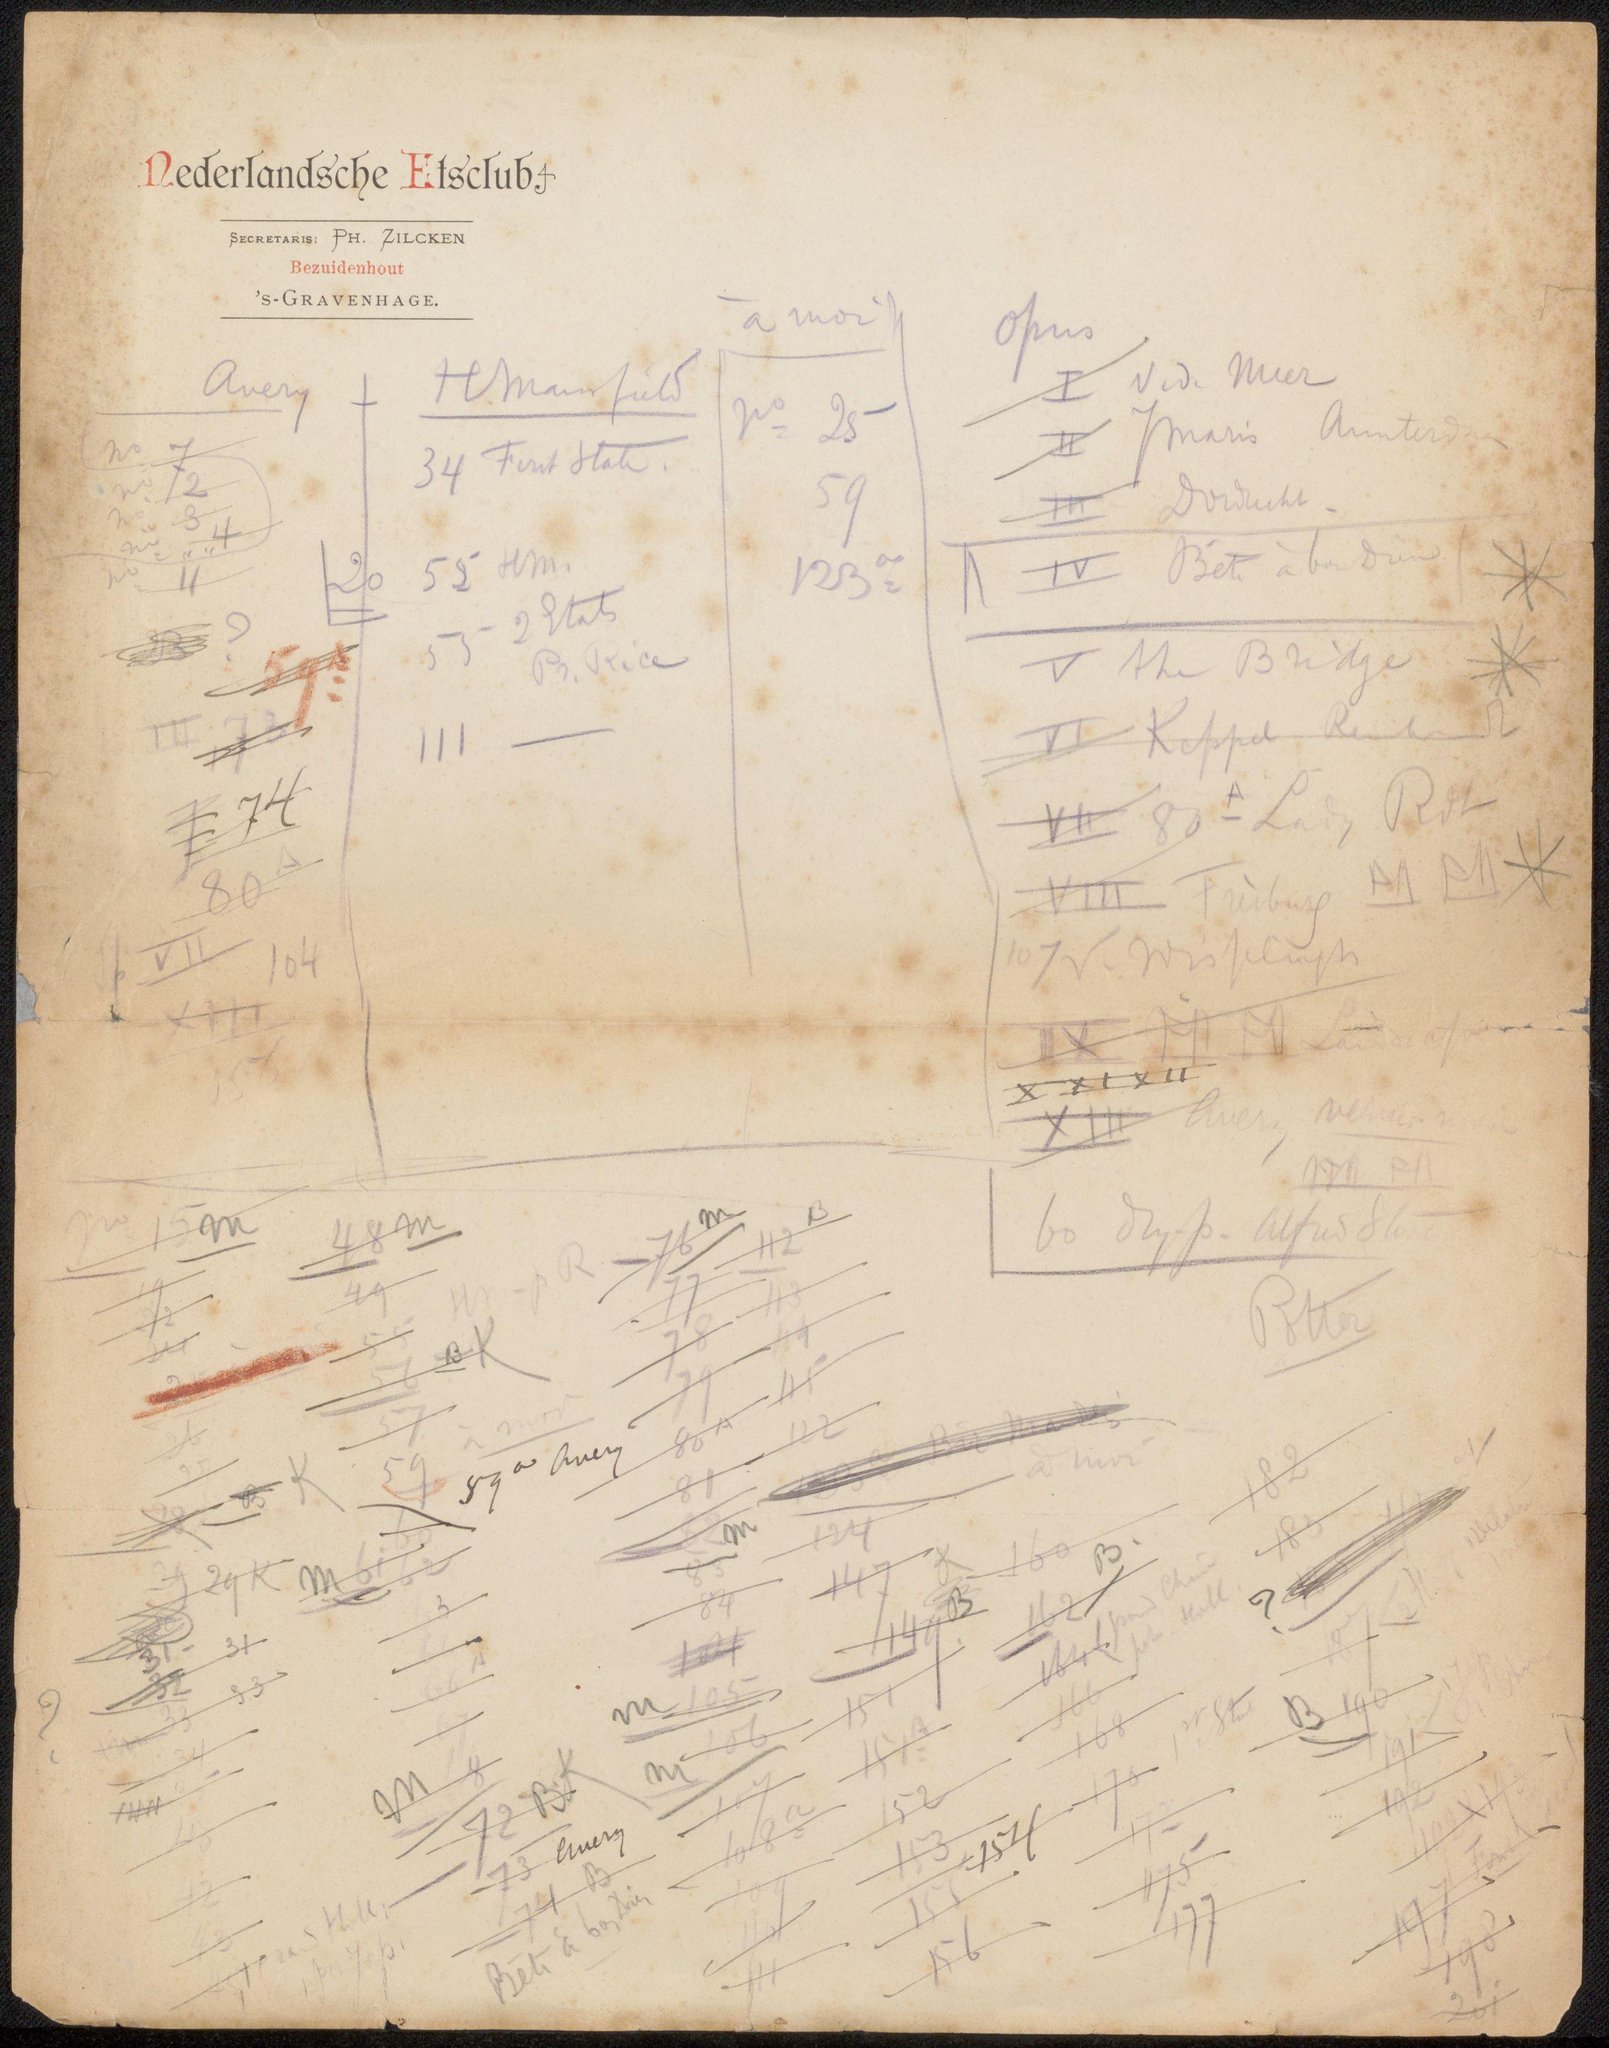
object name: aantekening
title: Aantekening uit archief Philip Zilcken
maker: philip zilcken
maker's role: draughtsman, painter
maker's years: 1857-1930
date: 1811-1890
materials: ink, paper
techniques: pen, printing, writing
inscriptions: collector's mark: ‘RPK’, watermark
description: Aantekeningen van Philip Zilcken op briefpapier van de Nederlandsche Etsclub.